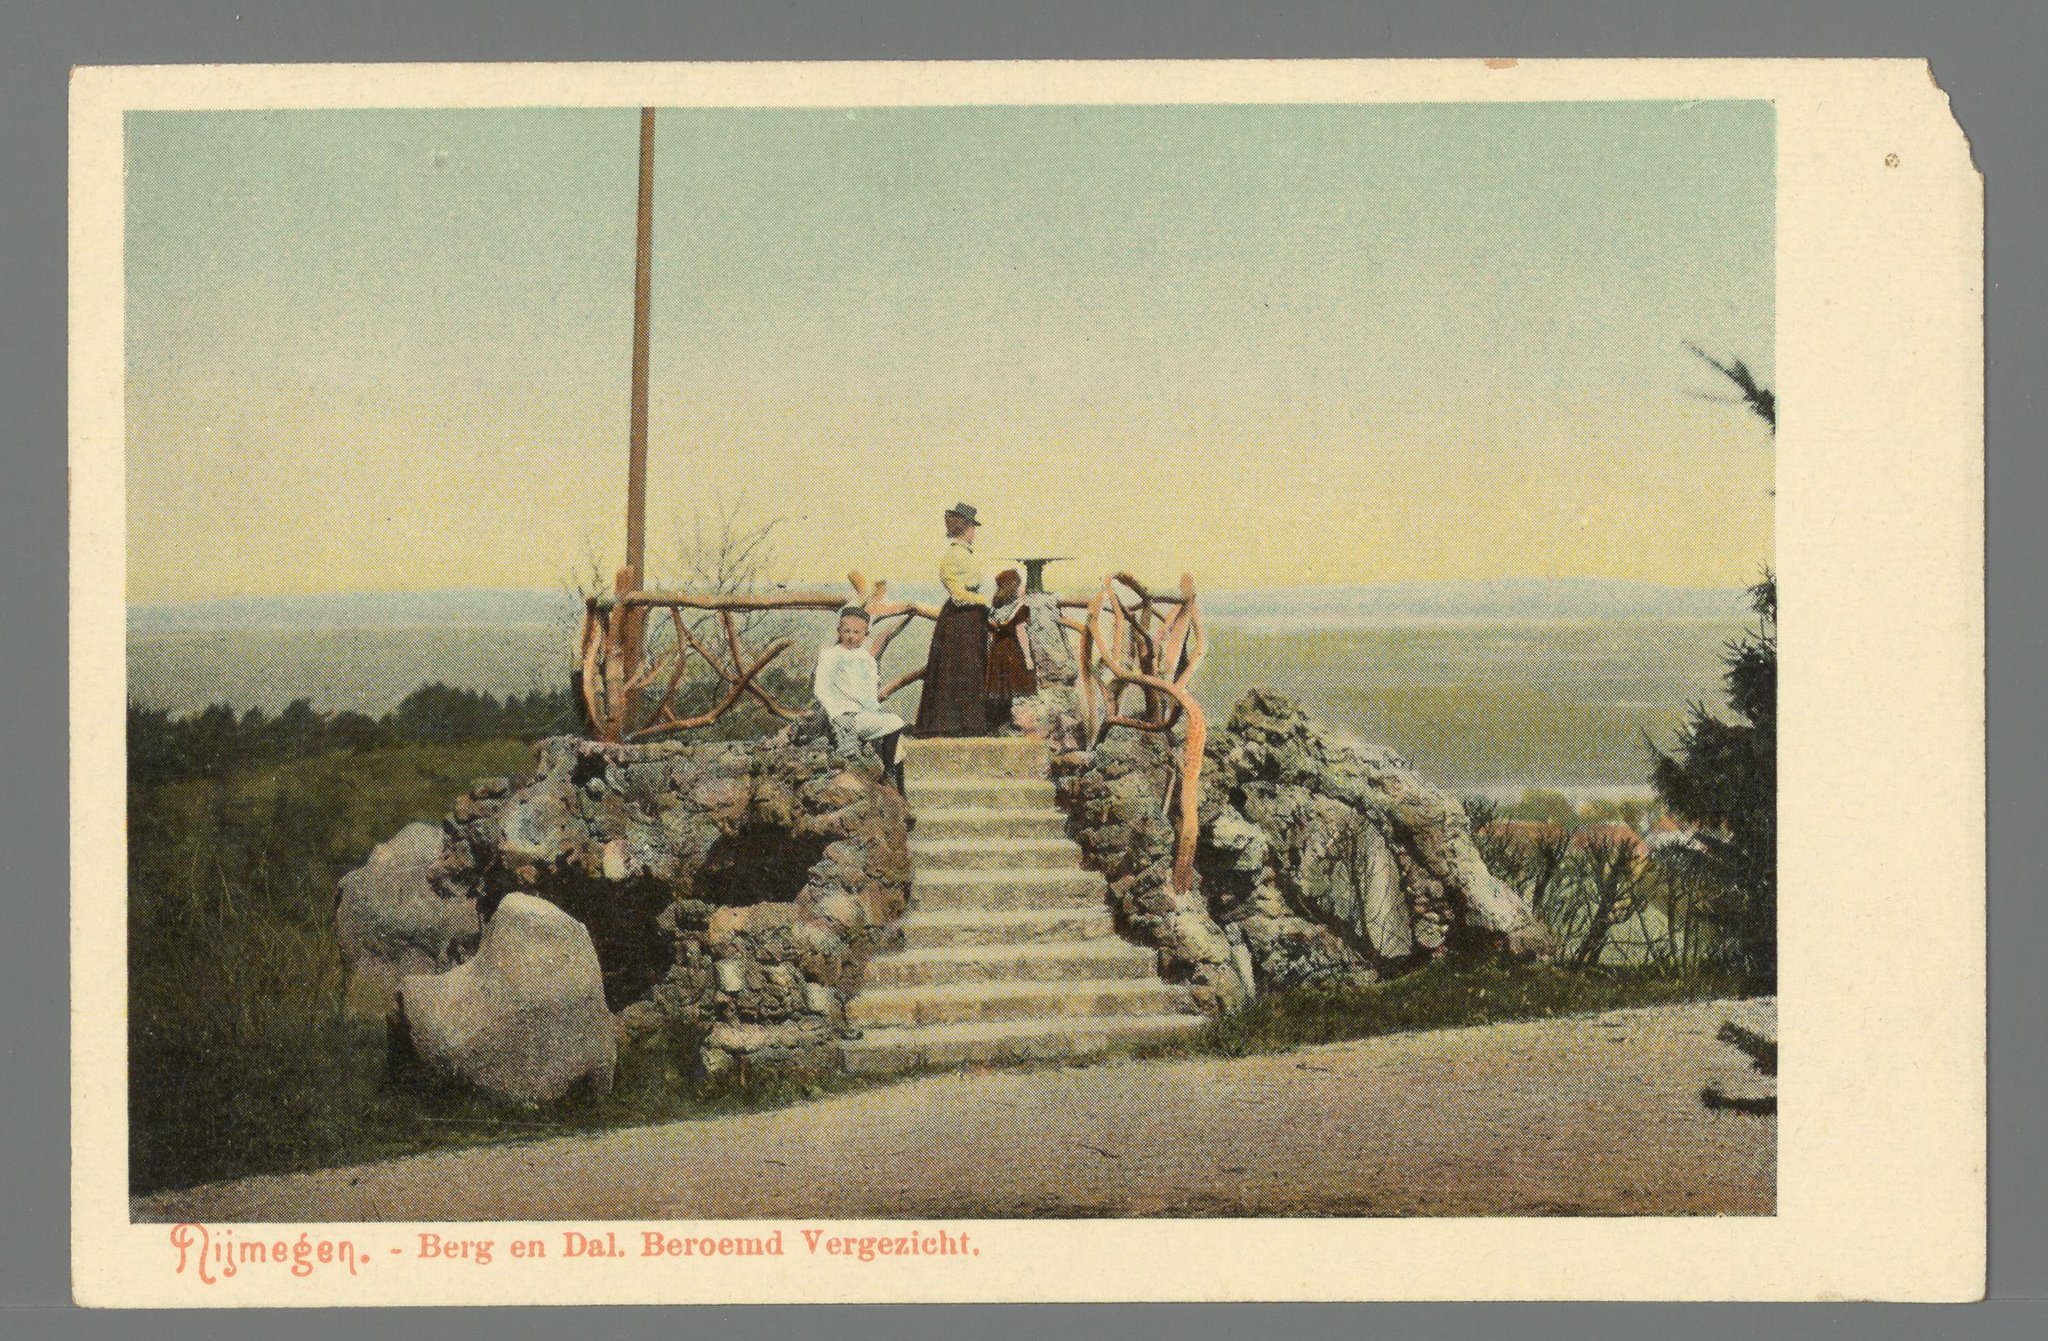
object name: ansichtkaart, prentbriefkaart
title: Nijmegen. - Berg en Dal. Beroemd Vergezicht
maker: Anonymous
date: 1905-1930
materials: cardboard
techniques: lithograph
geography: berg en dal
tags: prospect of village, silhouette of village